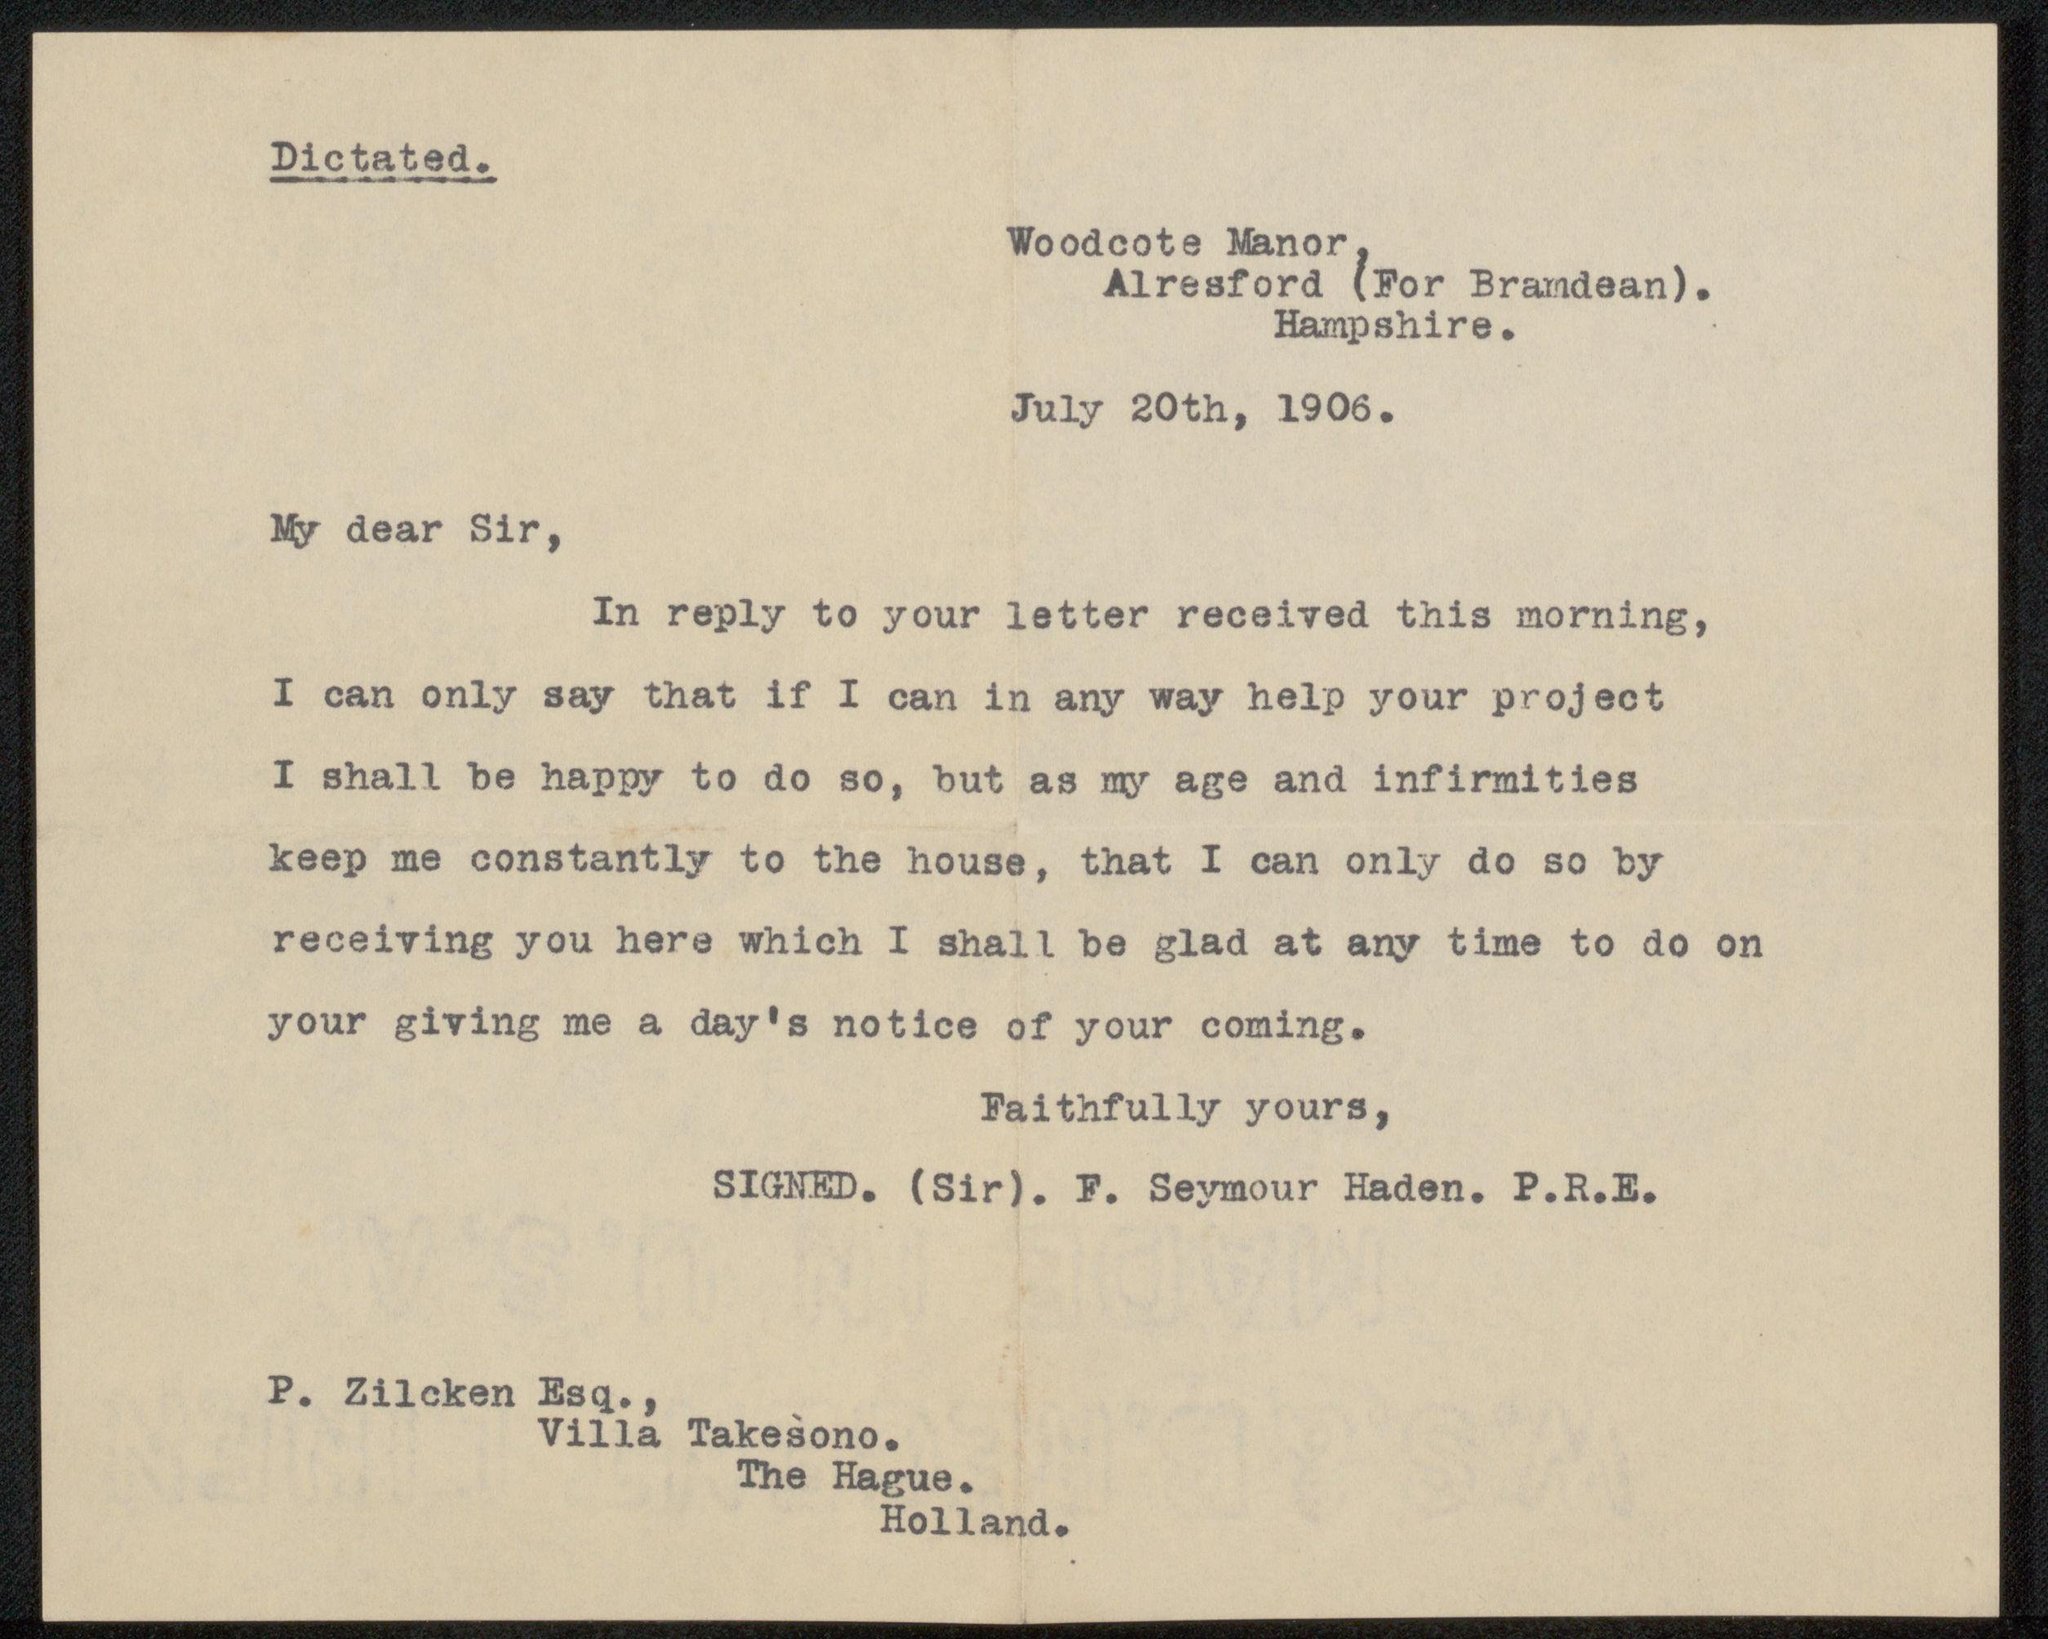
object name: letter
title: Brief aan Philip Zilcken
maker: francis seymour-haden (sir)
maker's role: print maker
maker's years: 1818-1910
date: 1906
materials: ink, paper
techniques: typewriting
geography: woodcote manor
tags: the hague, painter, draughtsman, philip zilcken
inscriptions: watermark, collector's mark: ‘RPK’